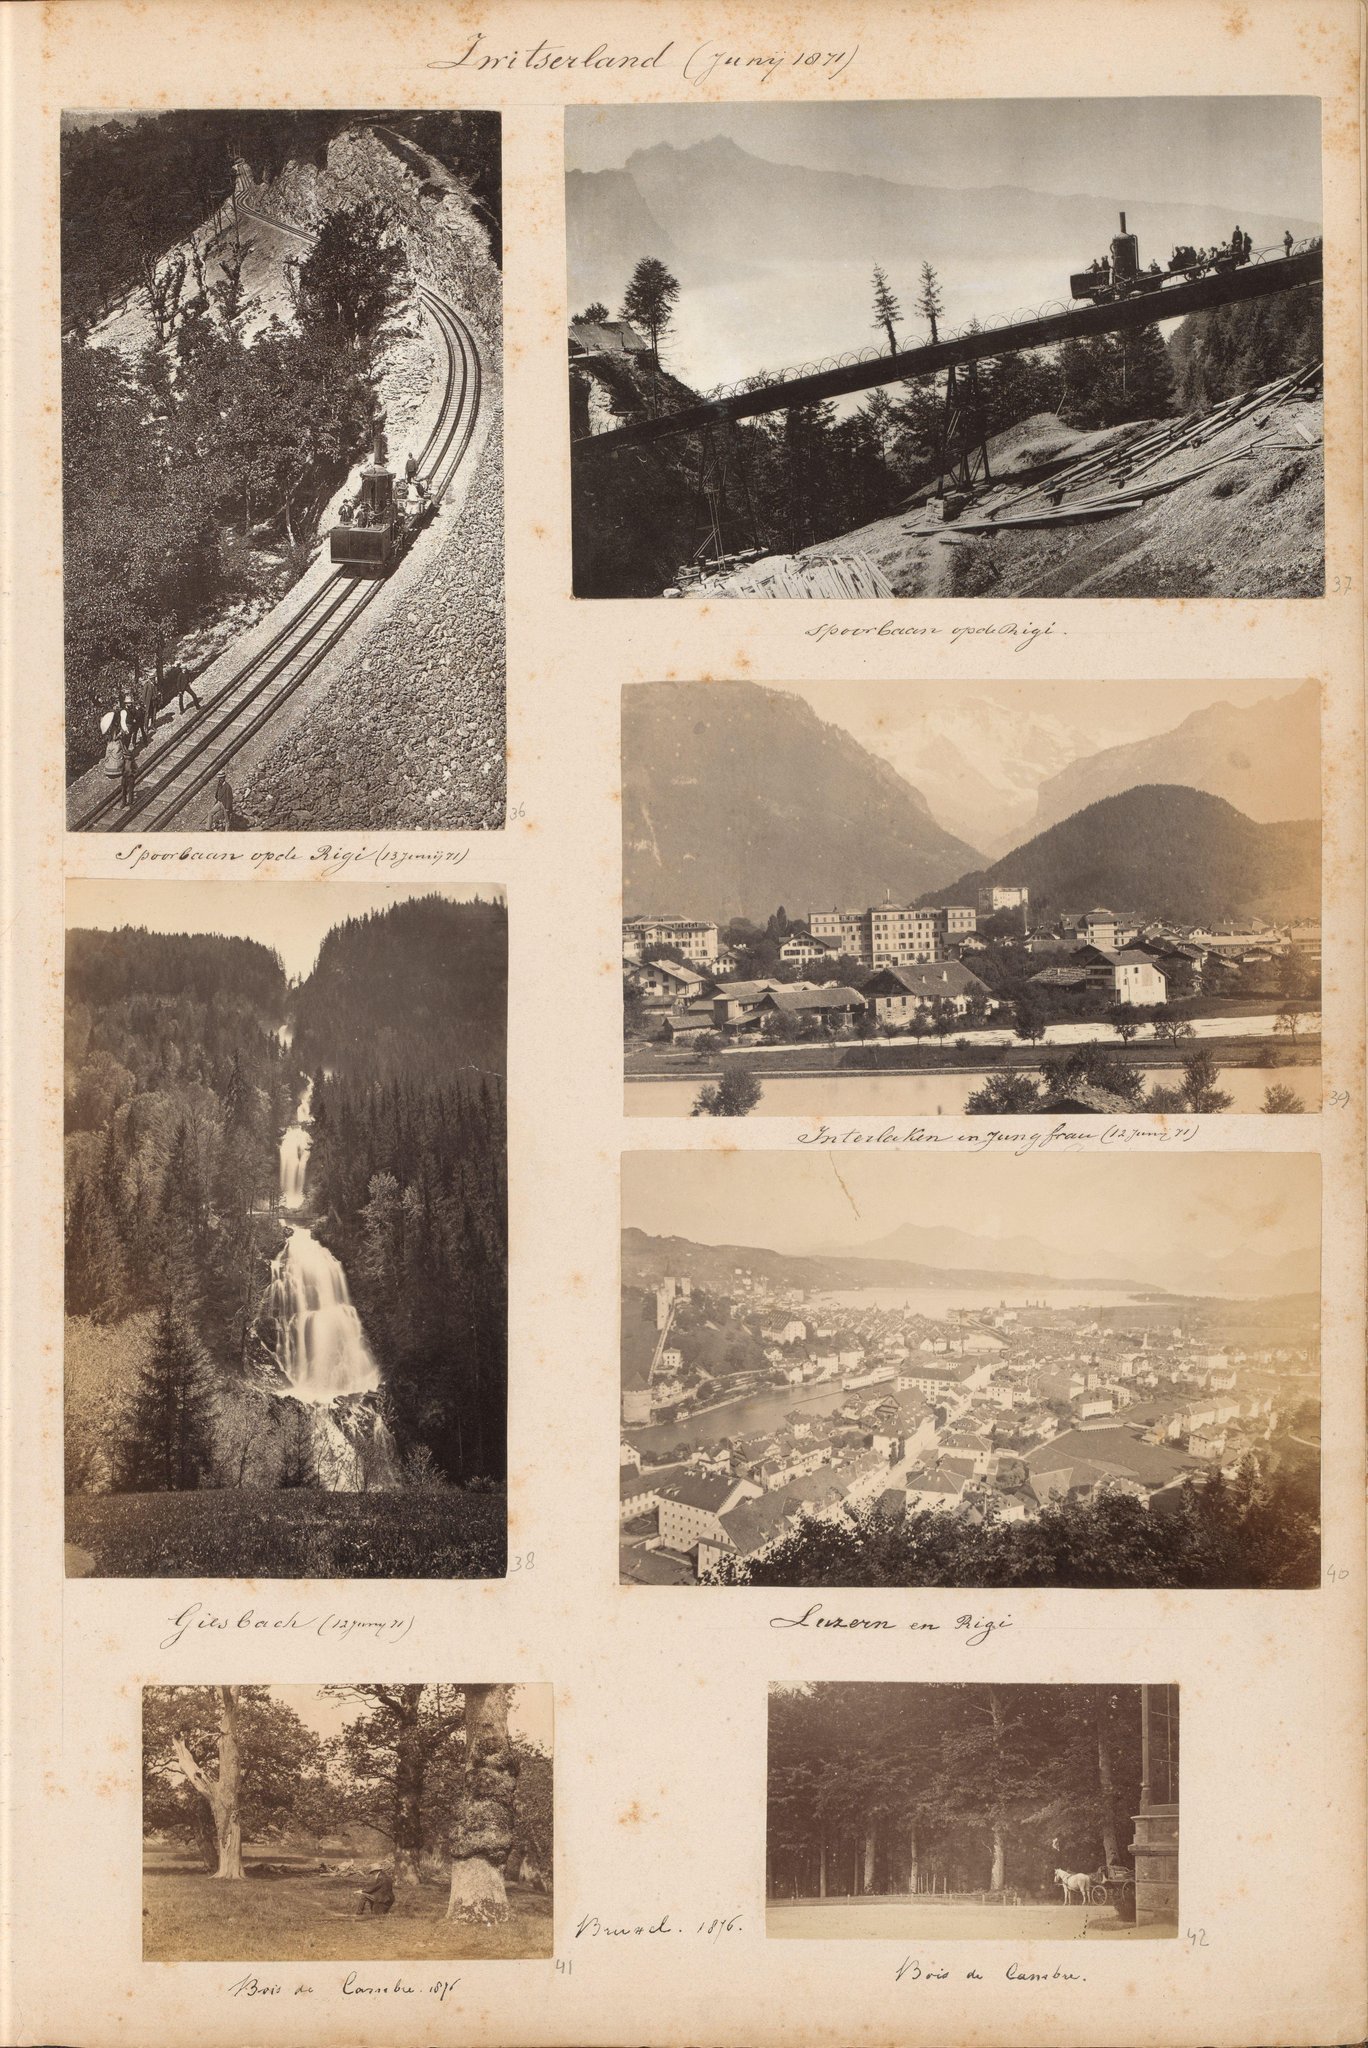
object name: photograph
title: Paard en wagen in het Ter Kamerenbos (Bois de la Cambre) te Brussel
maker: Anonymous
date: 1876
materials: paper, photographic support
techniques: albumen print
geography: brussels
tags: four-wheeled, animal-drawn vehicle, e.g.: cab, carriage, coach, forest, wood, public gardens, park, brussels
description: Onderdeel van Fotoalbum van Robert Daniel Crommelin (1841-1907).